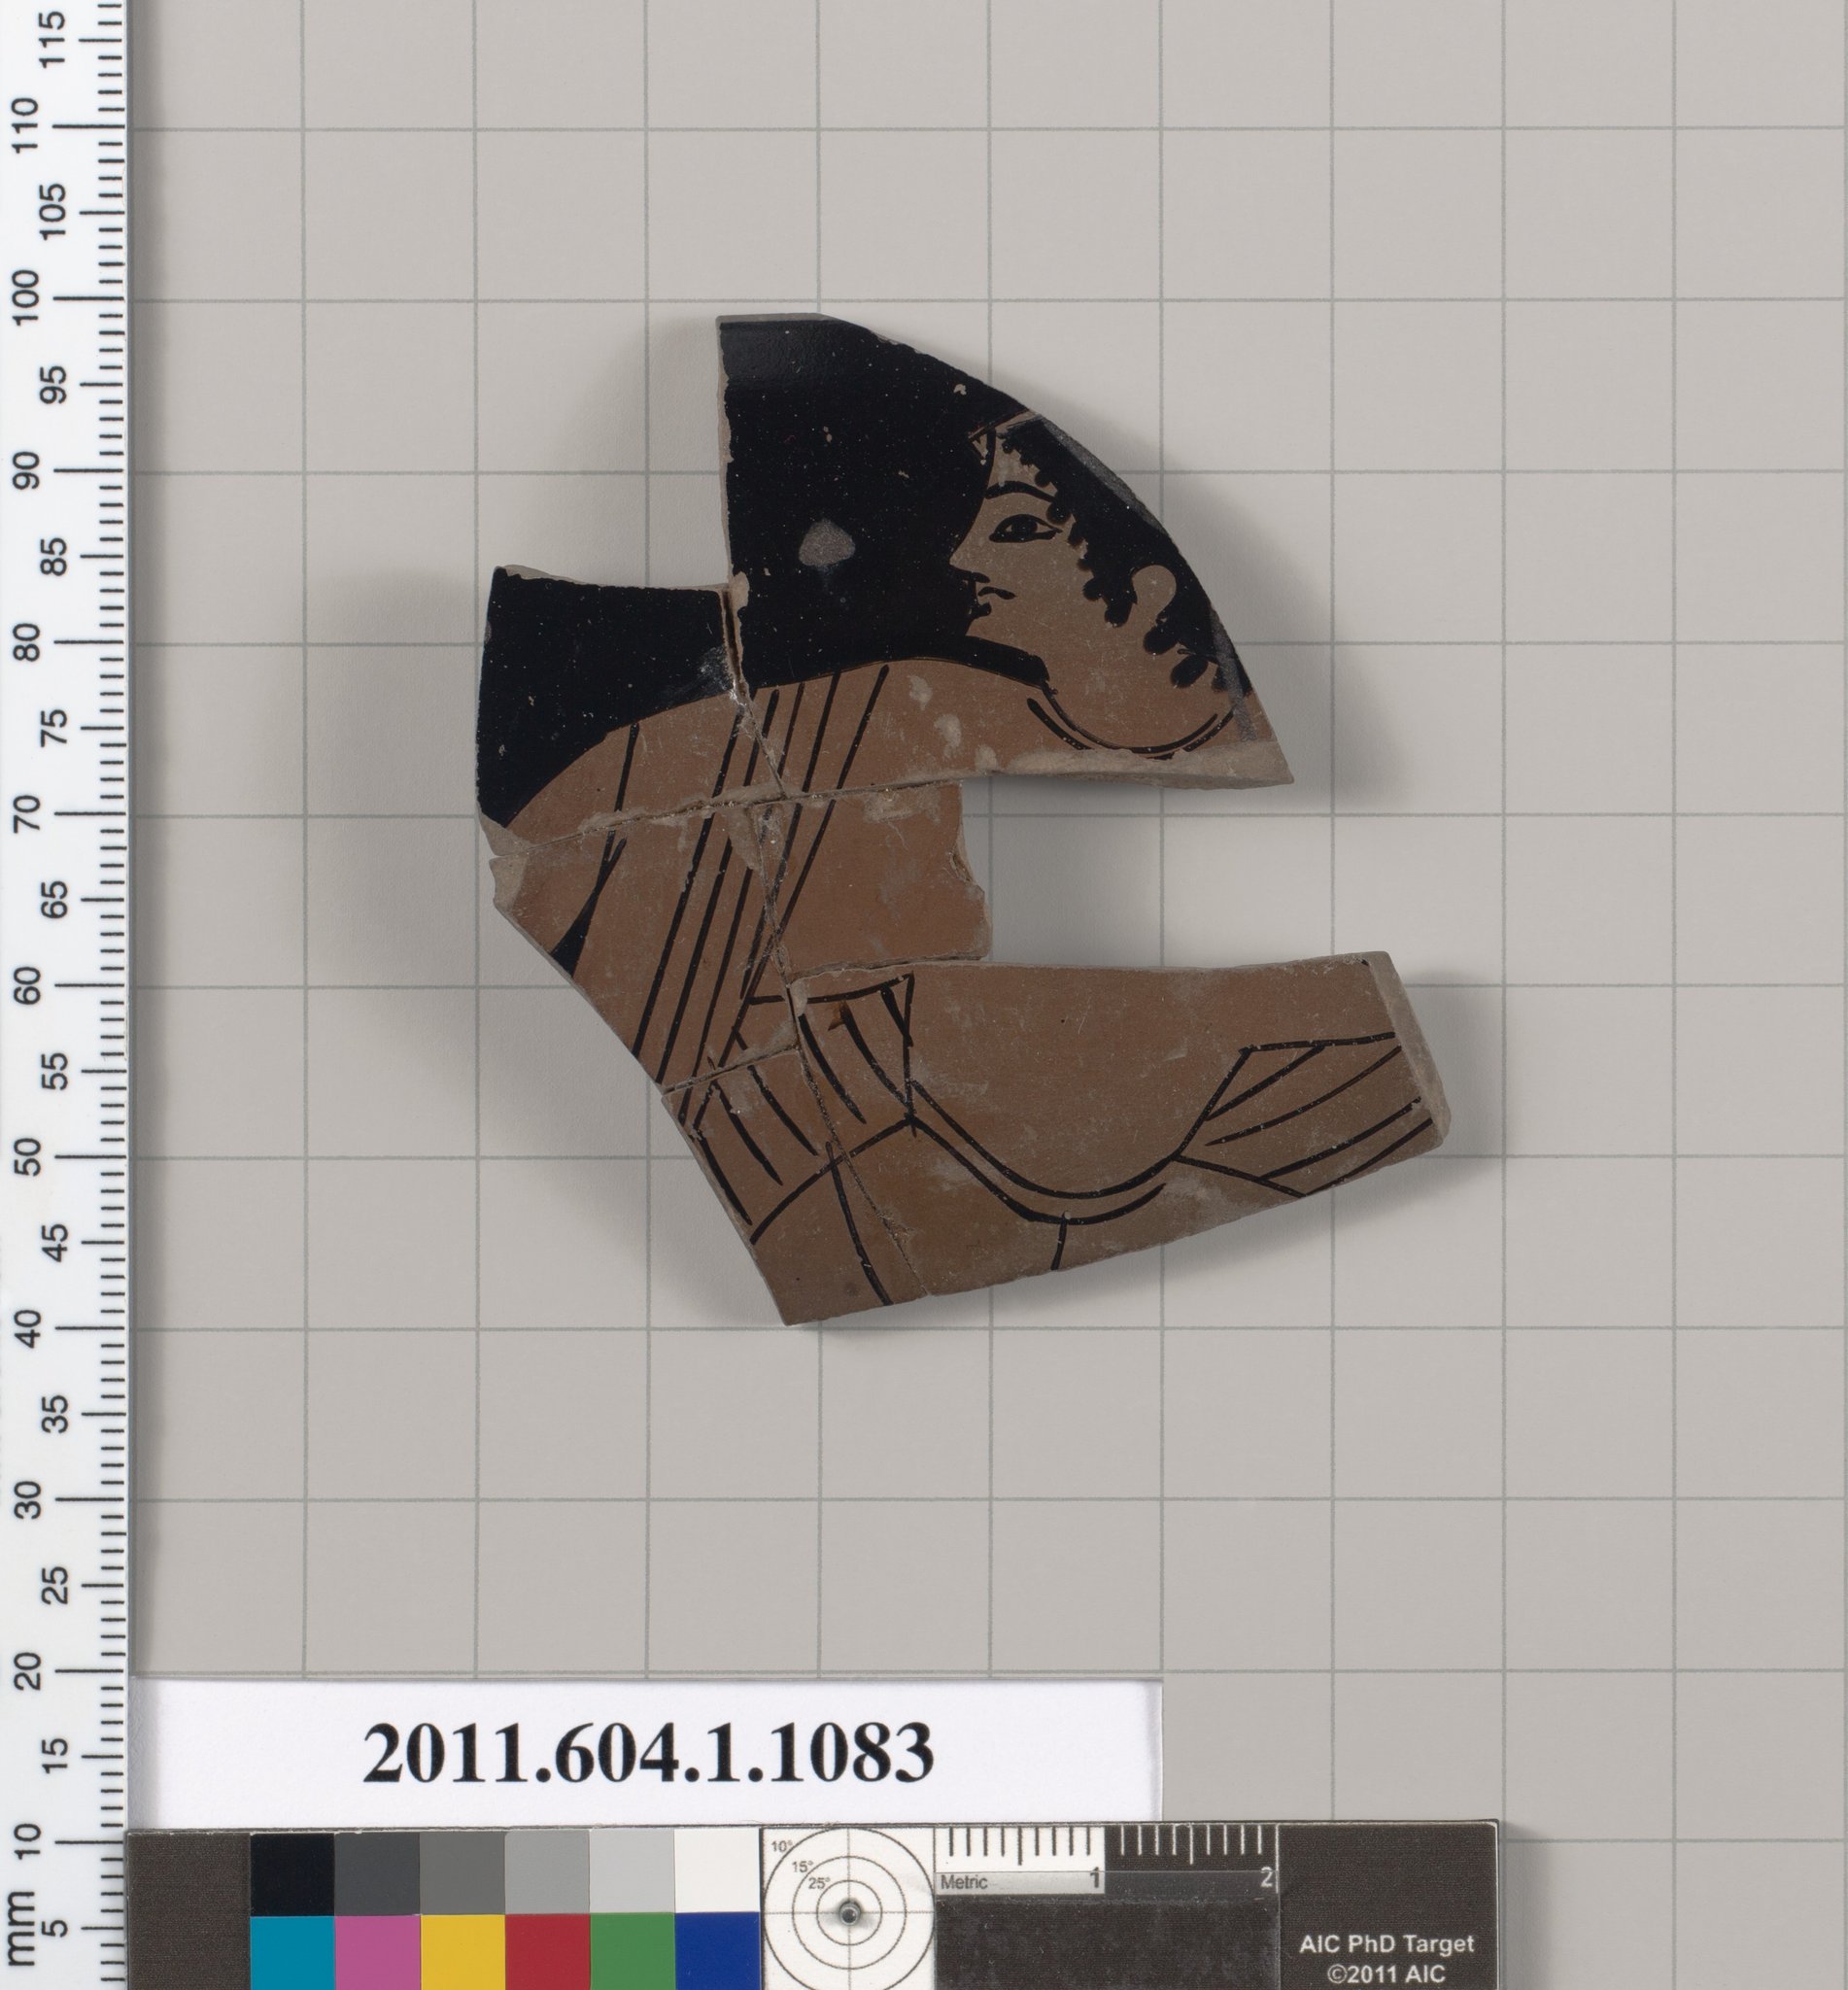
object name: kylix fragment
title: Terracotta fragment of a kylix (drinking cup)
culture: greek, attic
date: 510-500 BCE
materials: terracotta